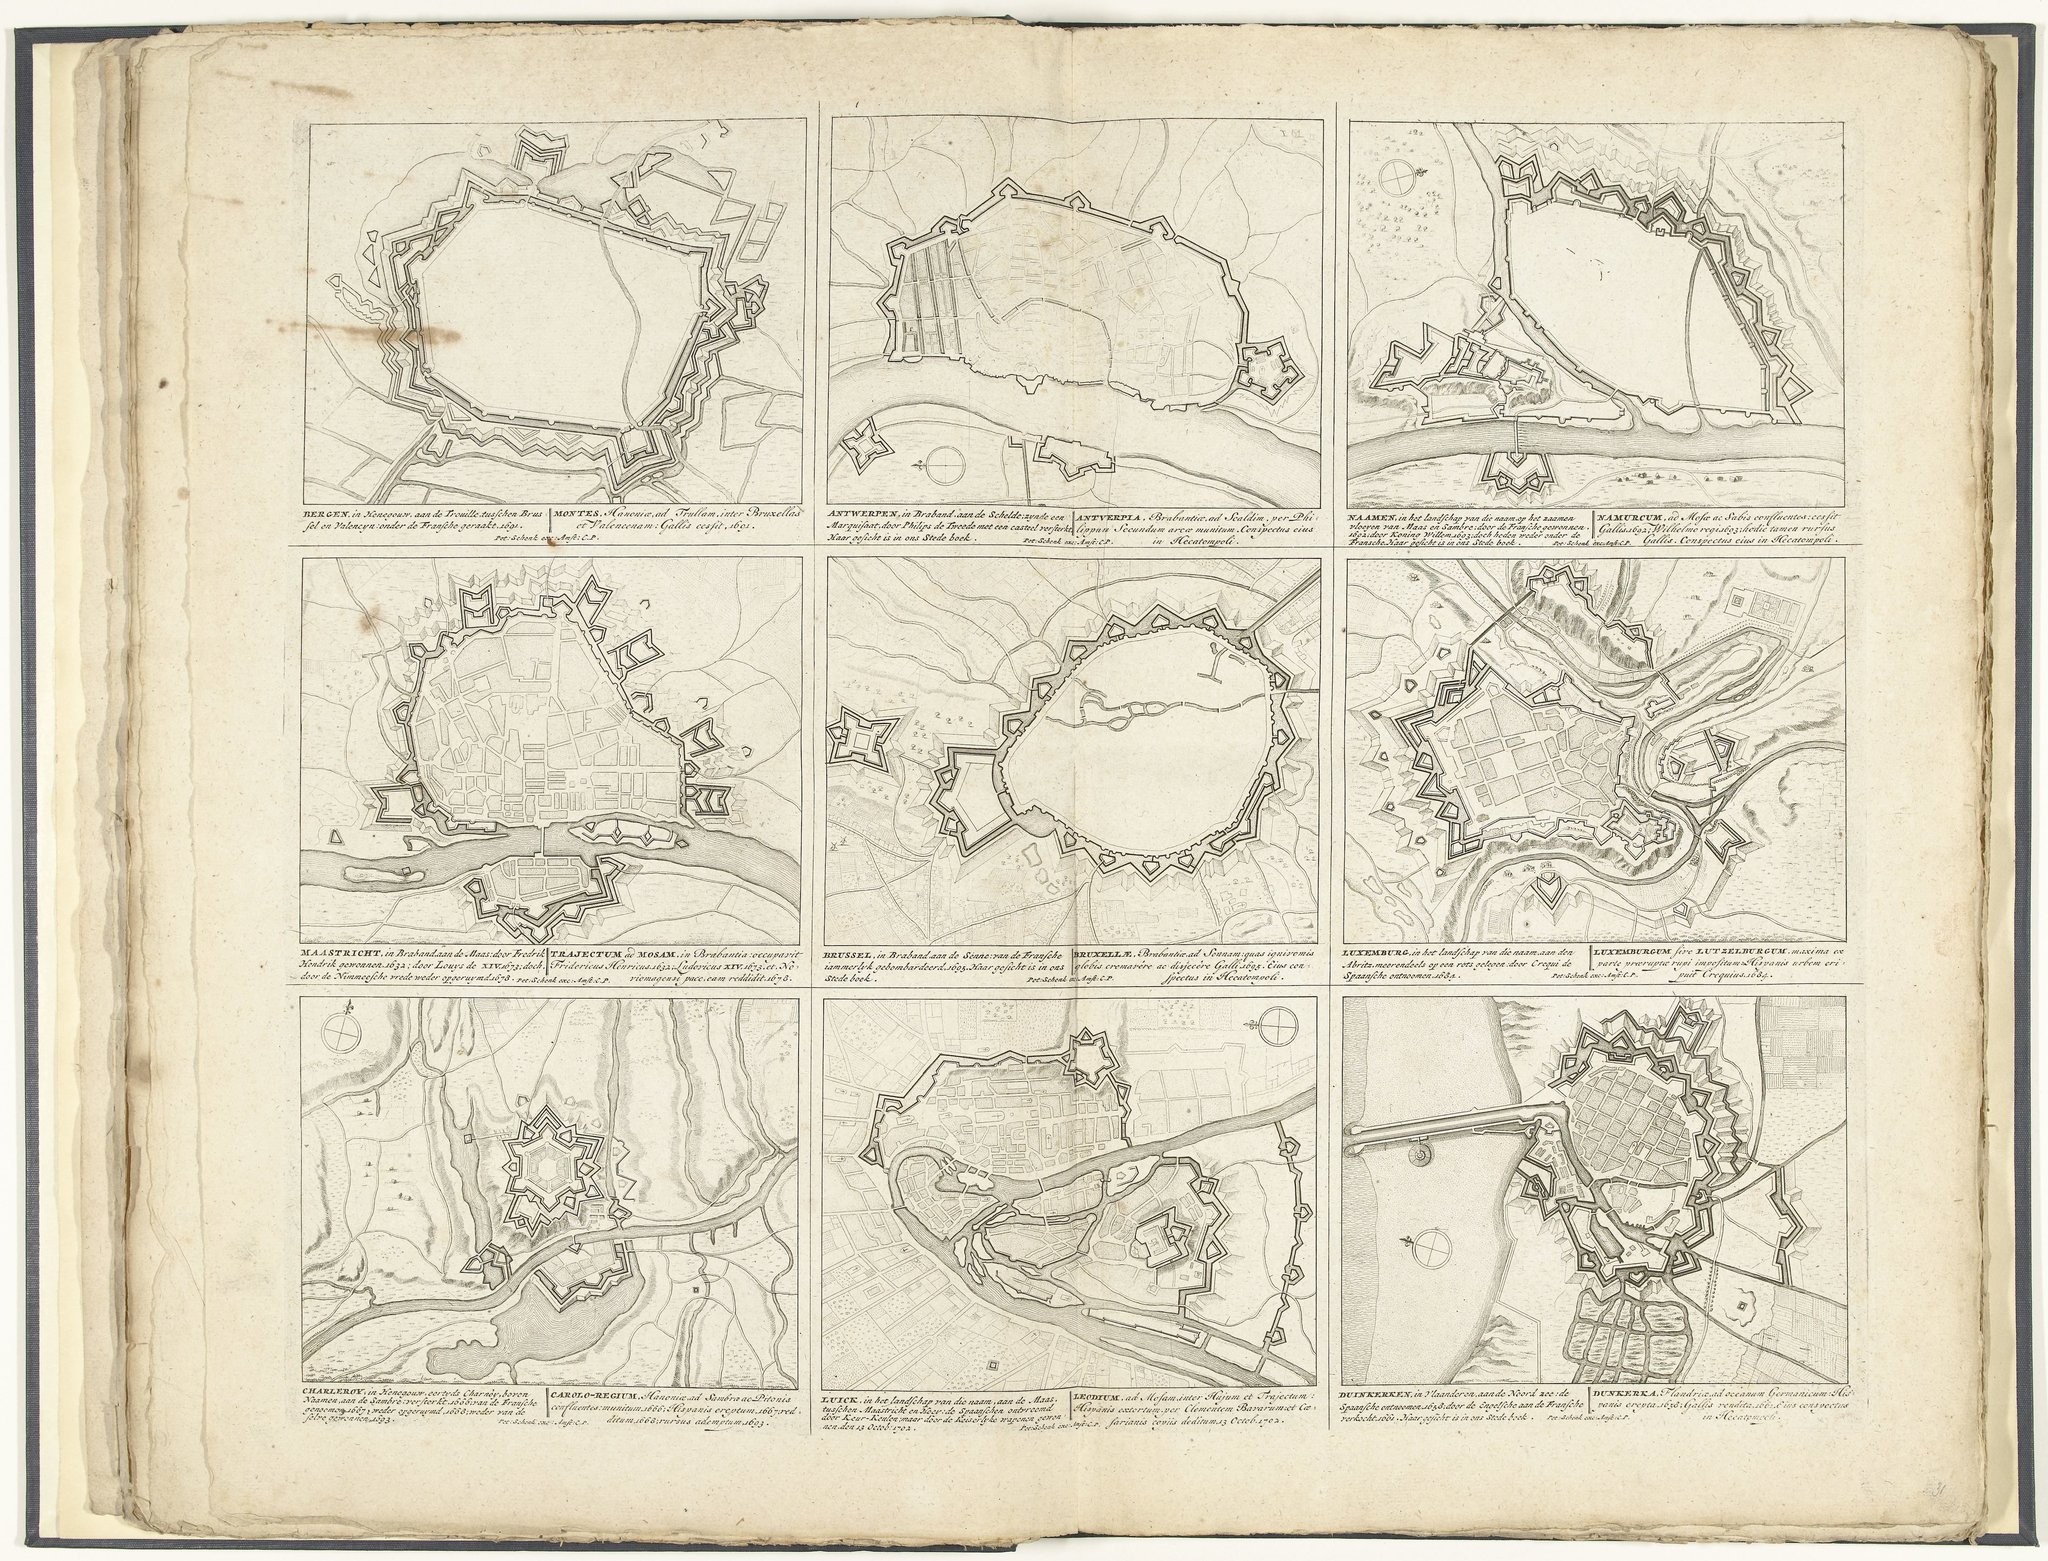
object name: print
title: Schouwtoneel van den Oorlog Beginnende met Koning Karel den tweeden Bestaande in Veldslagen, en Belegeringen, Zoo te Water als te Lande, met de voornaamste Vestingen (...)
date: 1700-1710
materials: paper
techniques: etching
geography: amsterdam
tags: fortress, maps of cities, antwerp, liège, brussels, maastricht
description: Blad met negen plattegronden van versterkte steden in de Zuidelijke Nederlanden en Noord-Frankrijk die in Spaanse Successieoorlog een rol speelden. Opschriften in de voorstelling in het Nederlands en Latijn. Plaat 5 in het prentwerk met de gebundelde reeks van 33 platen met voorstellingen (het merendeel verdeeld in 9 kleinere scènes) van gebeurtenissen uit de jaren 1700-1727 van de Spaanse Successieoorlog en de jaren daarna, kaarten en plattegronden.